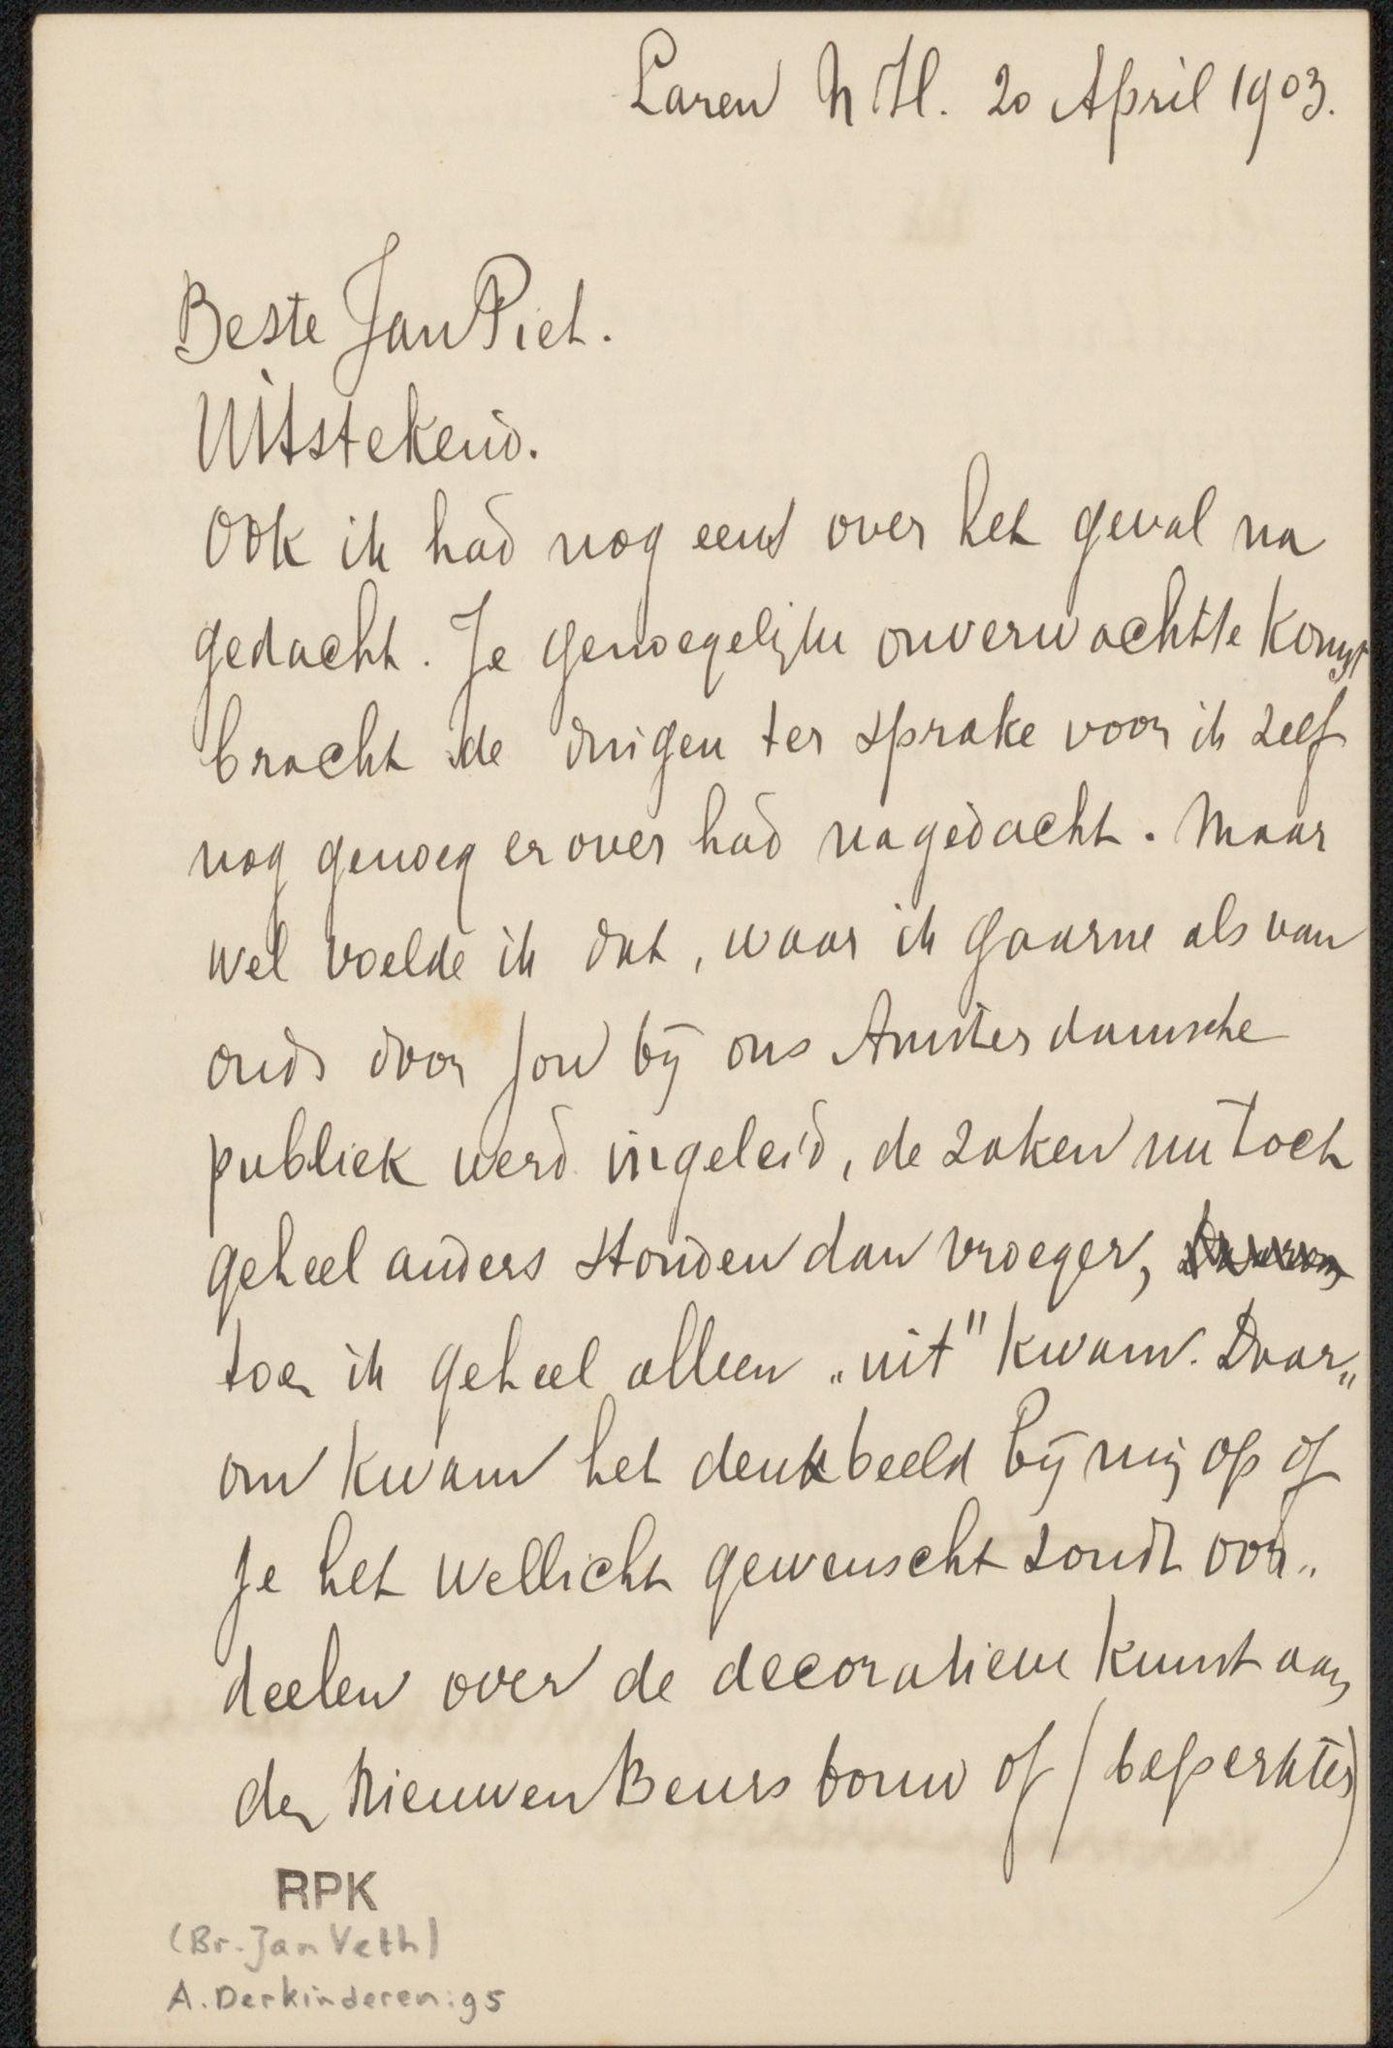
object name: letter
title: Brief aan Jan Veth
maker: antoon derkinderen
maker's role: draughtsman, painter, print maker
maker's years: 1859-1925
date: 1903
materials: ink, paper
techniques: pen, writing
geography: laren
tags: designer, jan veth, jan toorop, richard nicolaüs roland holst, applied arts, arts and crafts; industrial design, printed matter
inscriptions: collector's mark: ‘RPK’